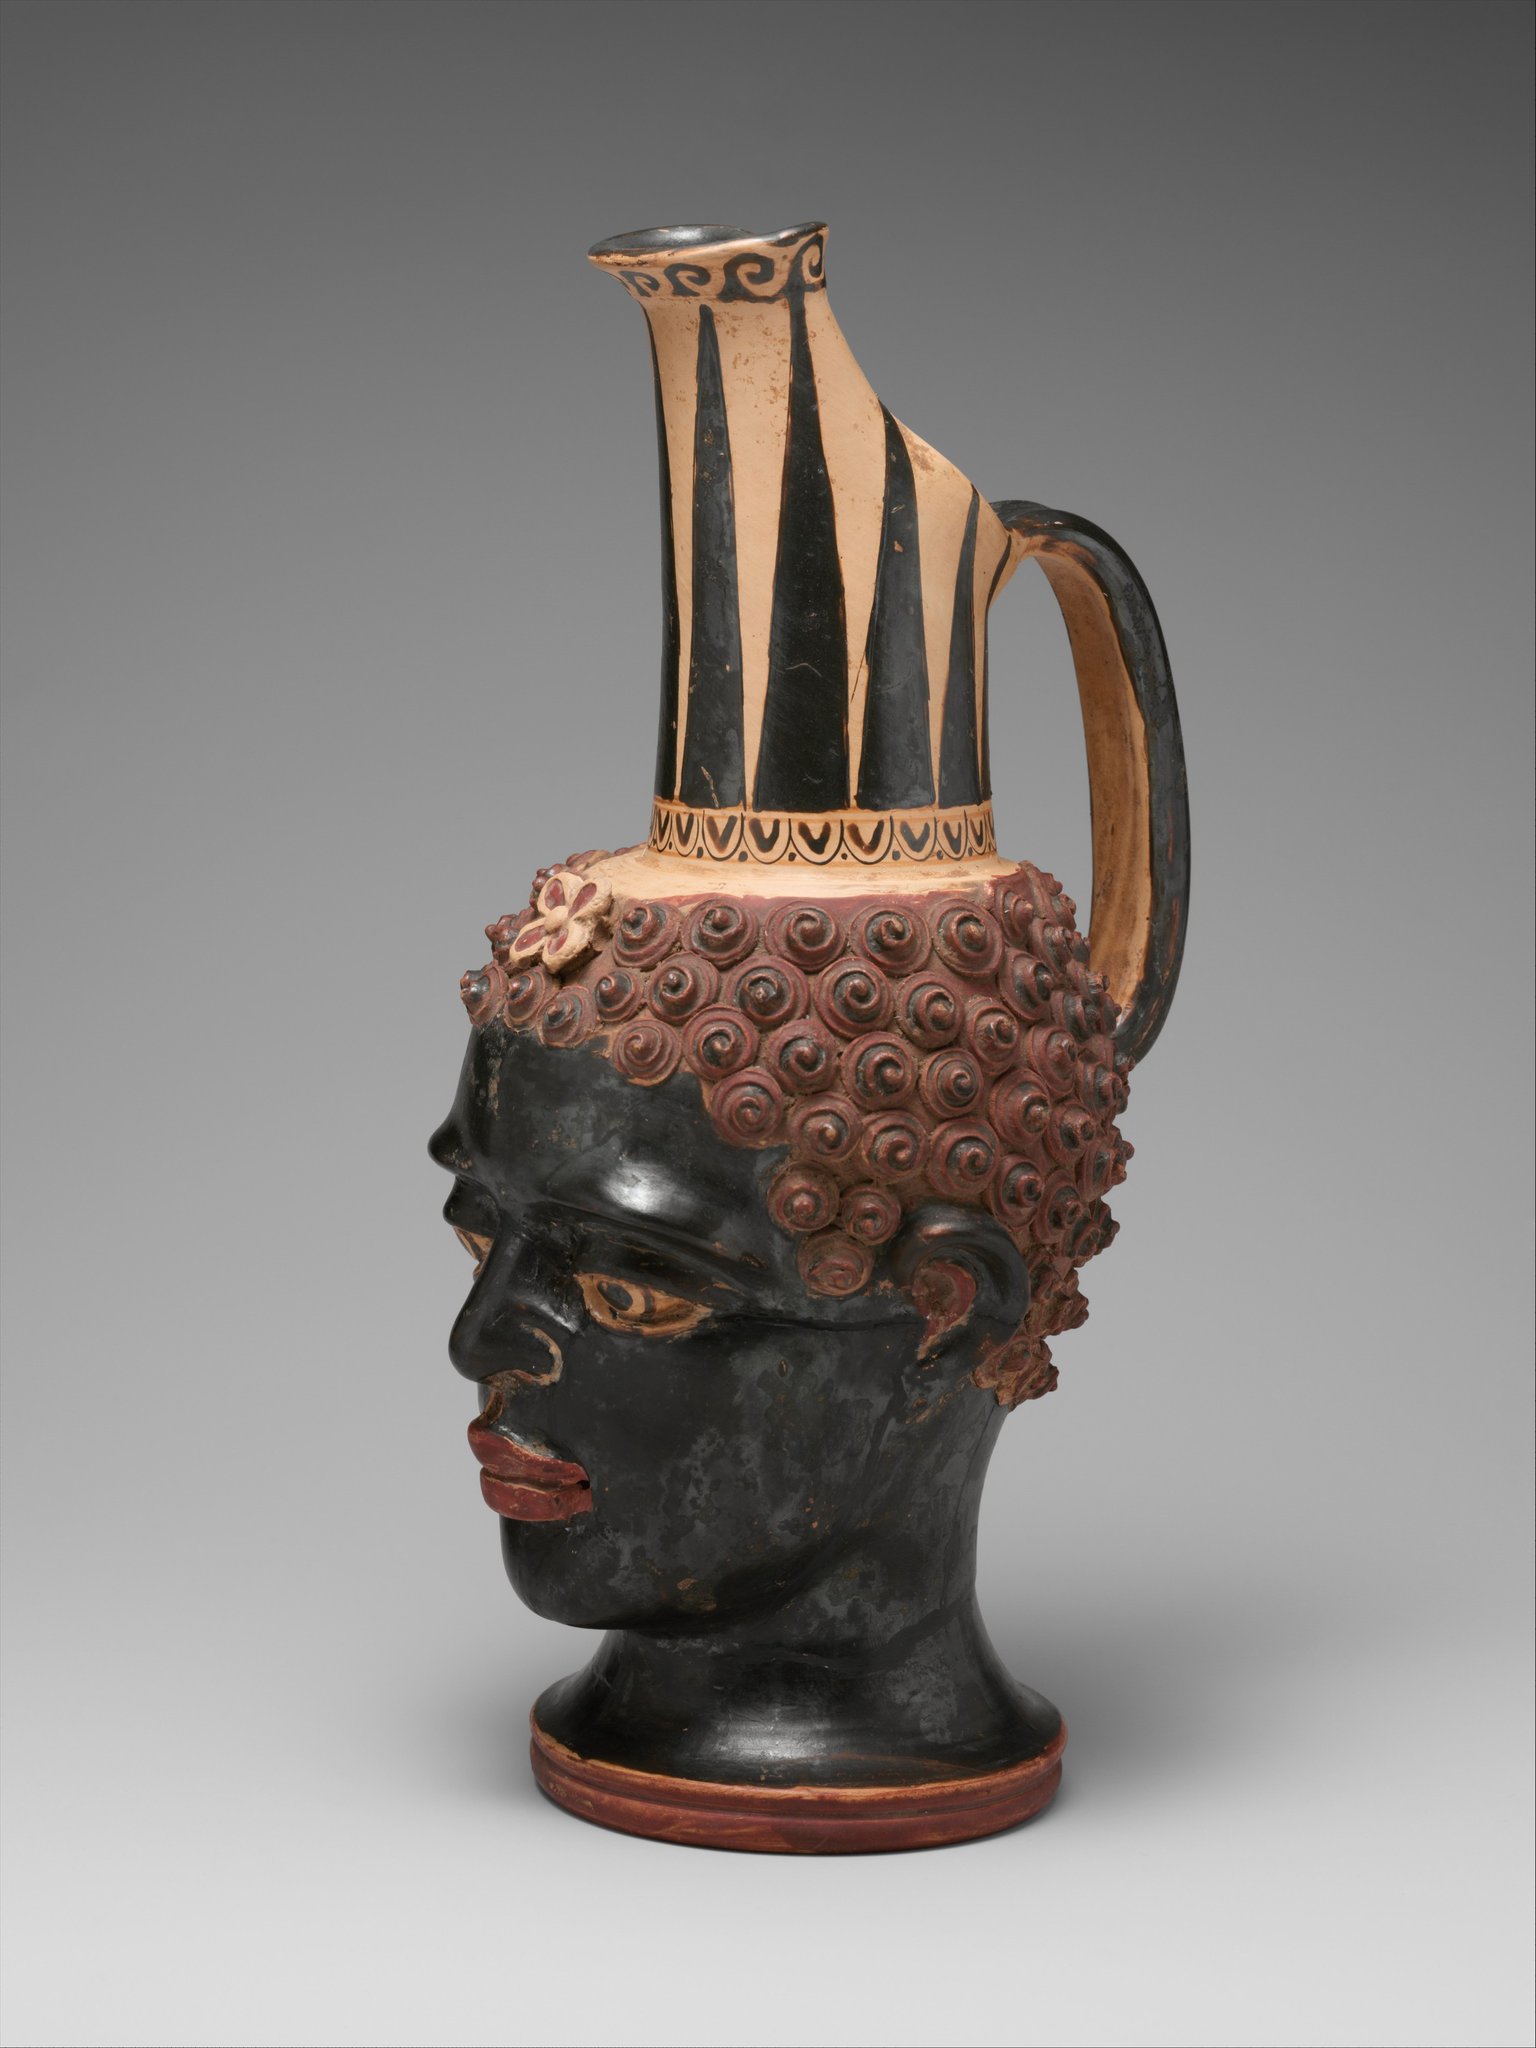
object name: vase in the form of a black african youth's head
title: Terracotta vase in the form of a Black African youth's head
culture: etruscan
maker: negro boy group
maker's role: artist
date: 400-301 BCE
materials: terracotta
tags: heads,boys